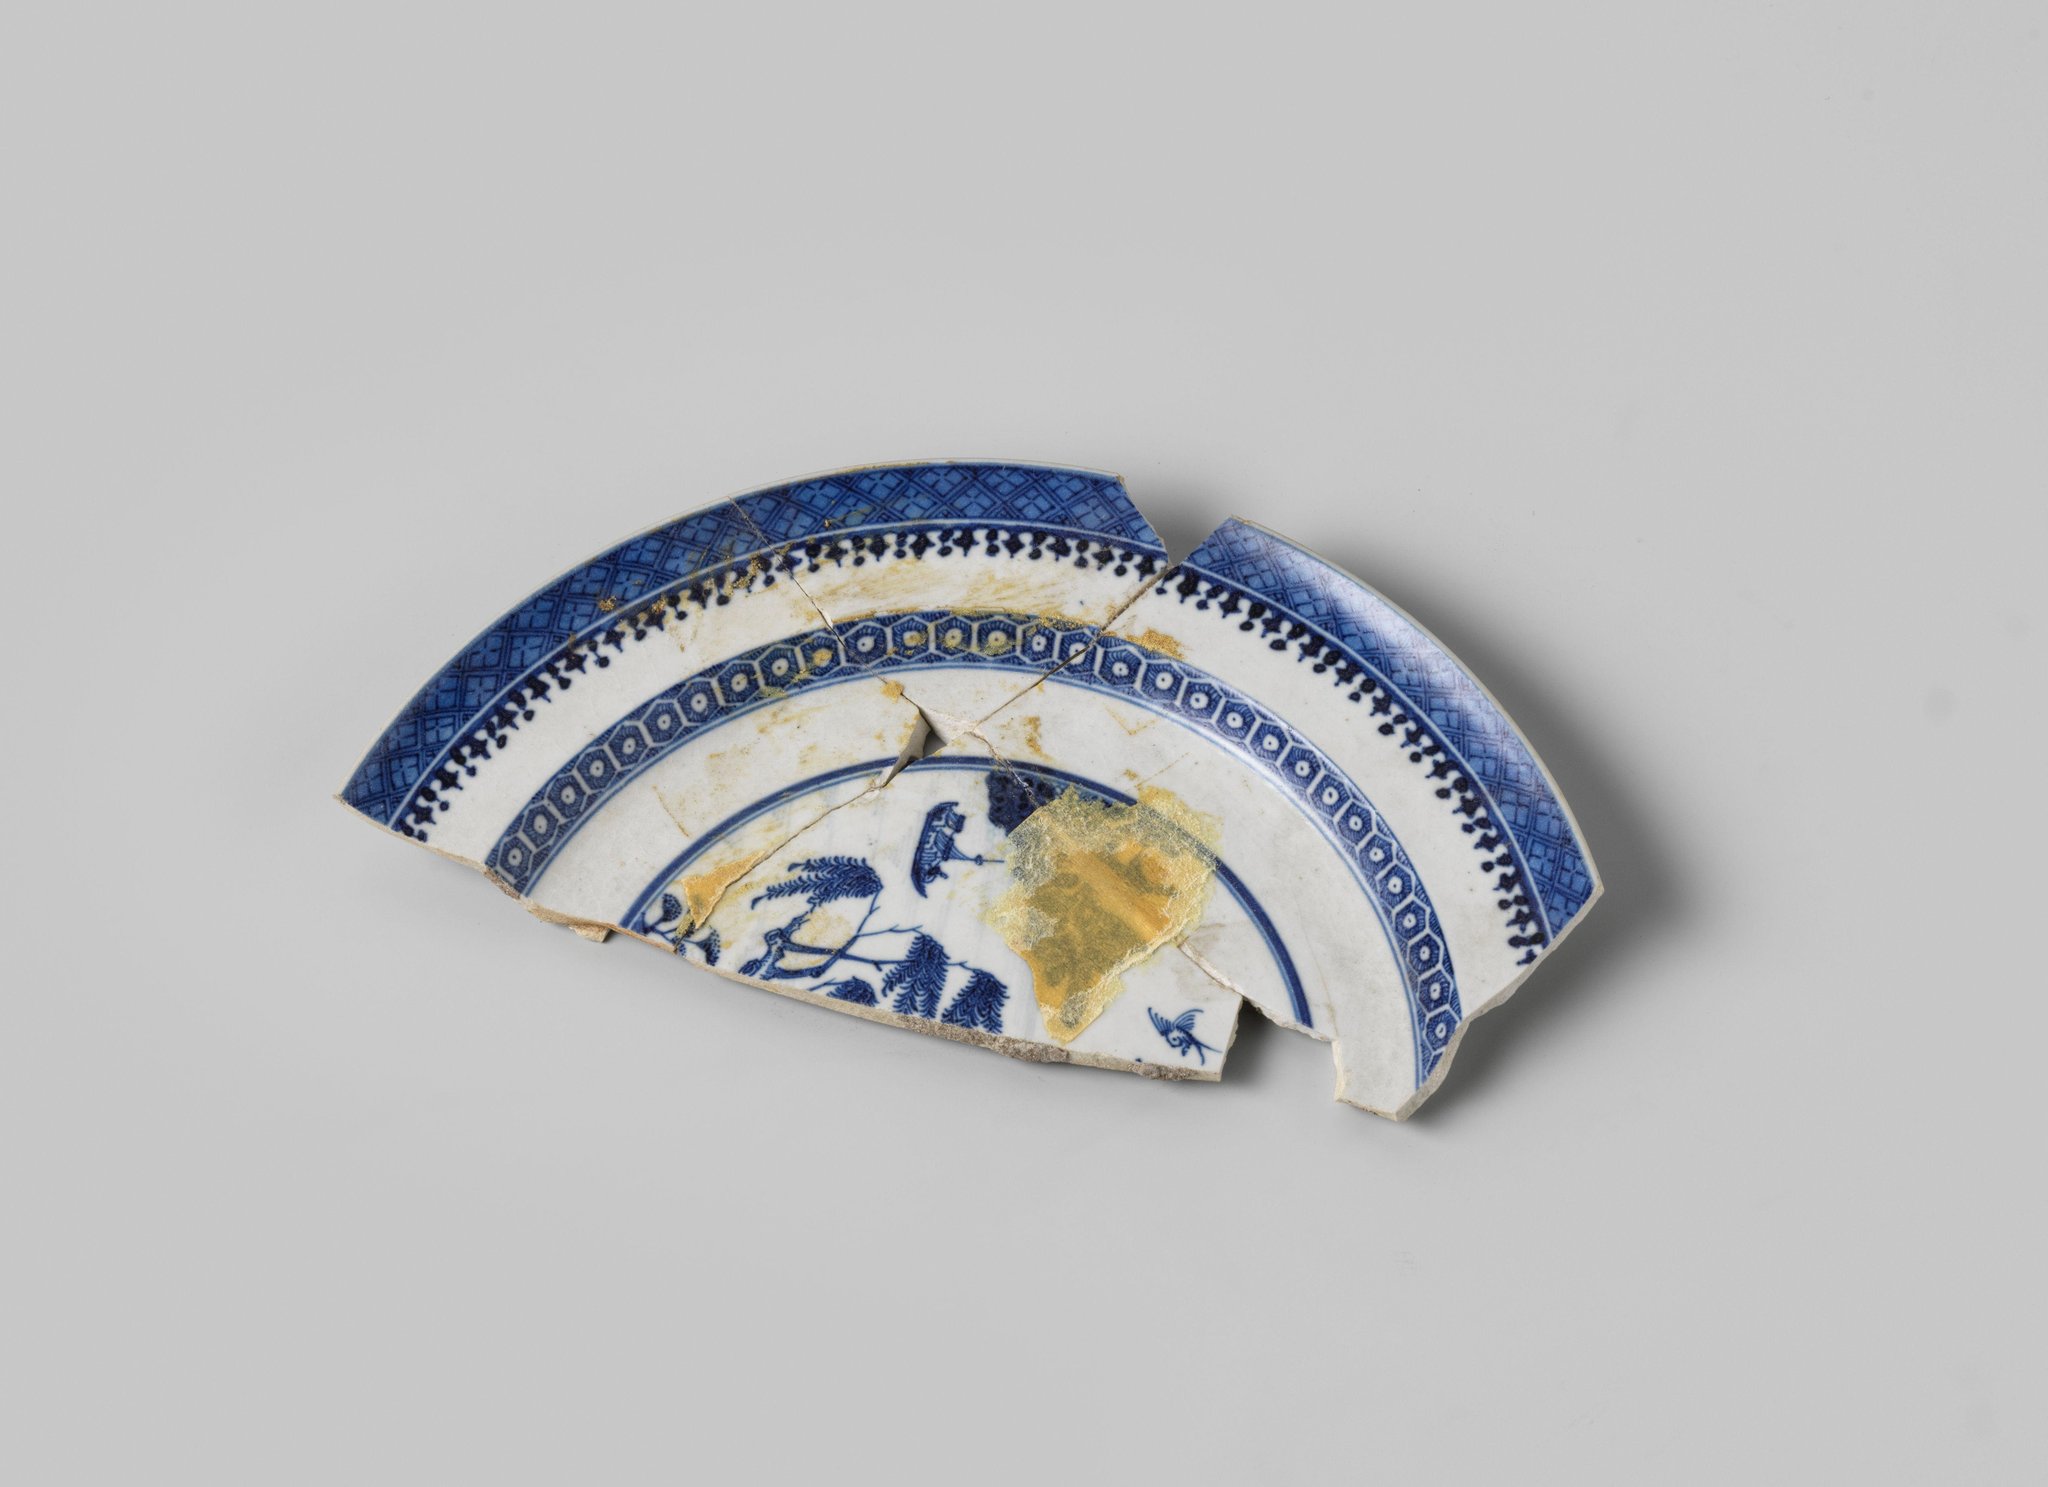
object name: plate dish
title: Porseleinen bord, gevonden bij V.O.C.-schip Witte Leeuw, mogelijk afkomstig van Zeelelie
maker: Anonymous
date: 1775-1800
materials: porcelain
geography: jingdezhen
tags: verenigde oostindische compagnie, sint-helena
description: Porseleinen bord, bestaande uit vier aan elkaar gelijmde fragmenten, gevonden bij V.O.C.-schip de 'Witte Leeuw', ca. 45% aanwezig. Dit object is 18e-eeuws en kan dus niet van de vracht van de Witte Leeuw zijn. Onduidelijk is of het object van de site komt of dat het later is vermengd, mogelijk met materiaal van de Zeelelie.